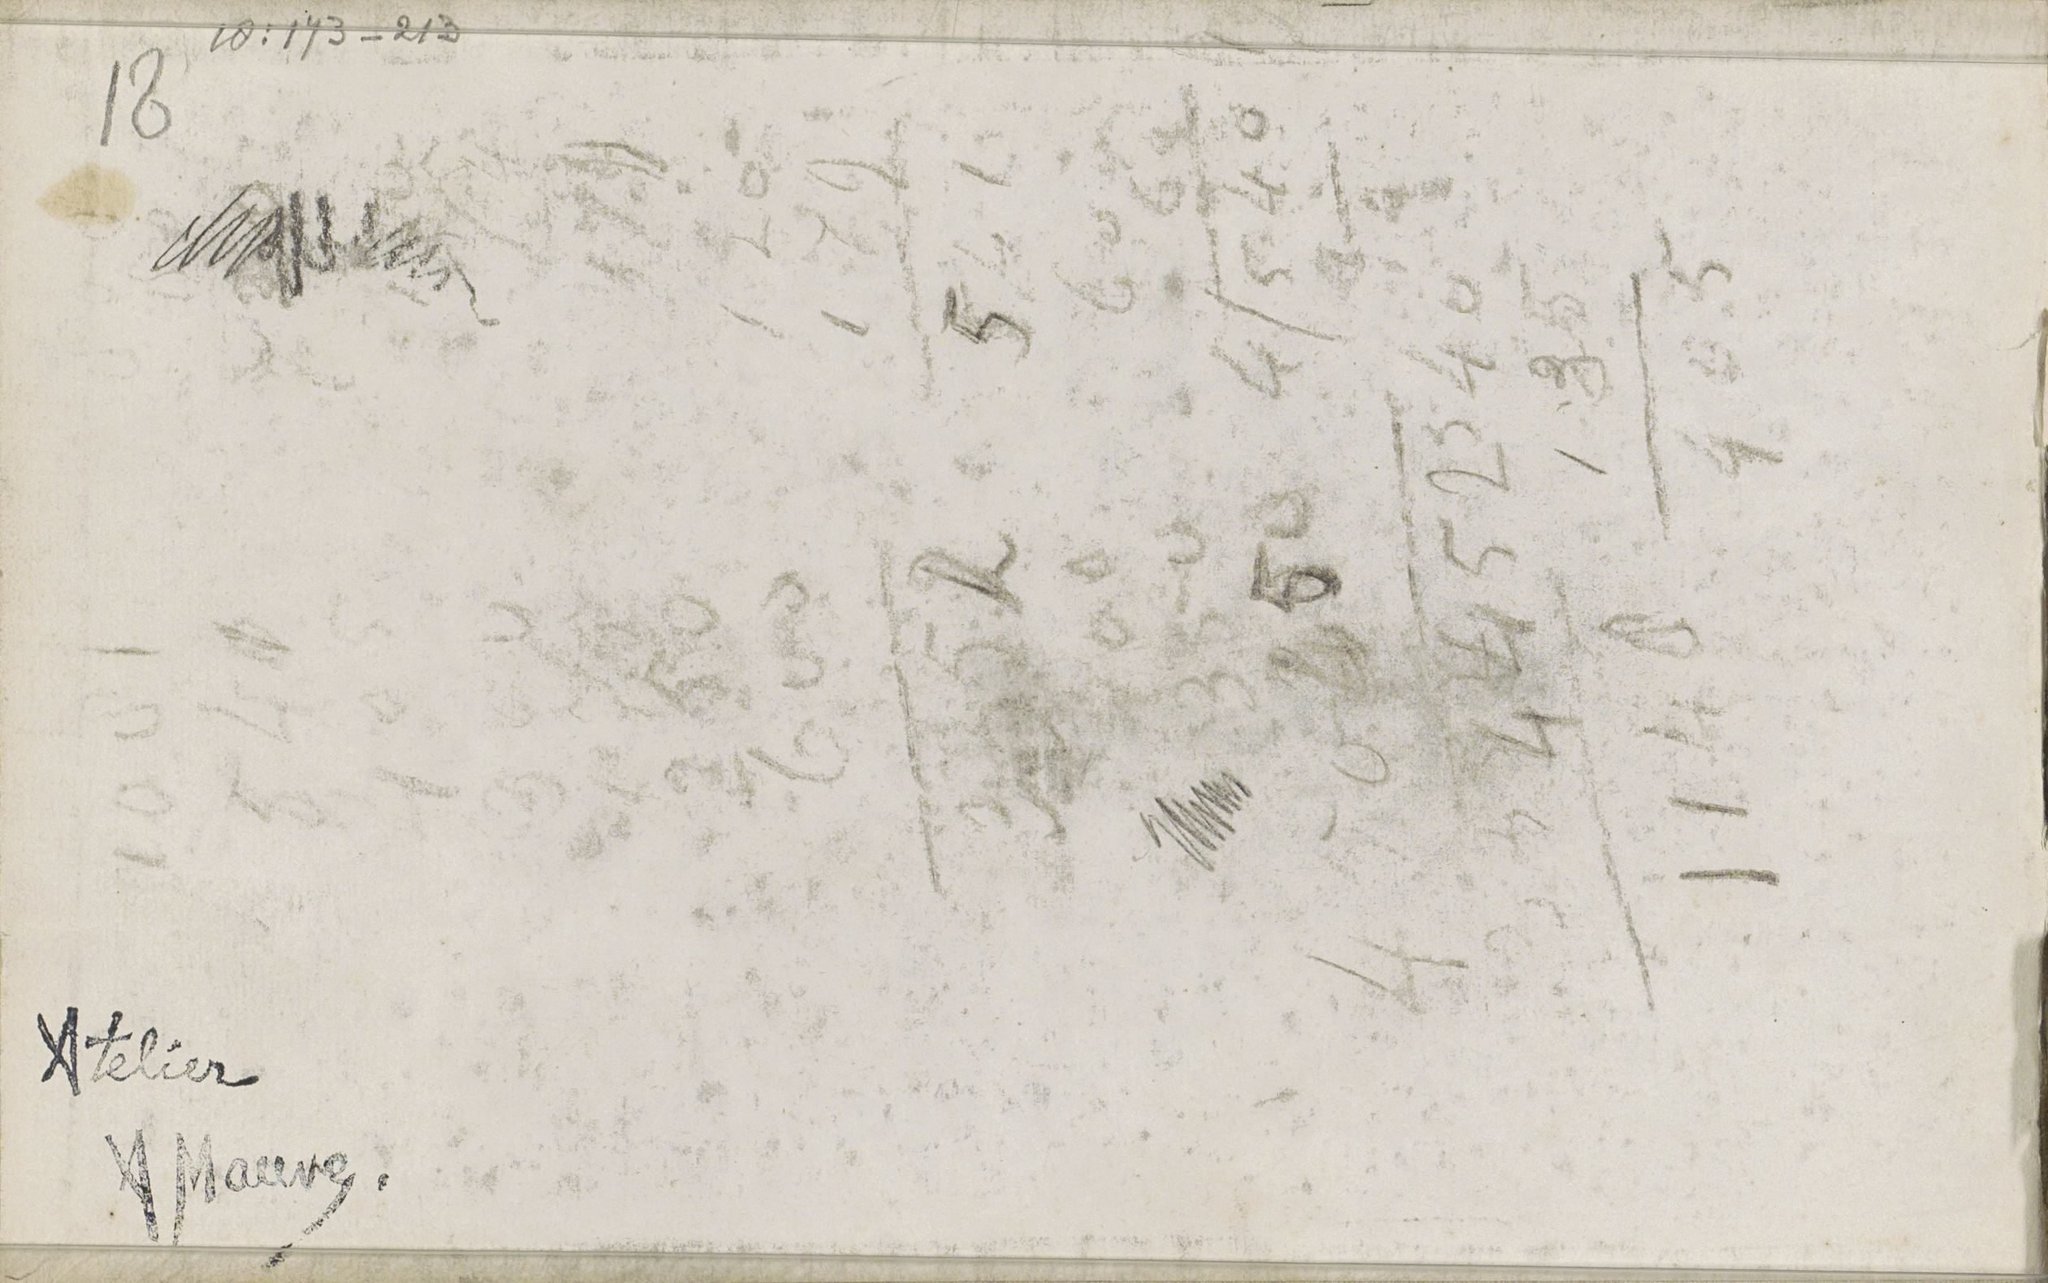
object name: sketchbook leaf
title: Berekeningen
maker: anton mauve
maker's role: draughtsman, painter, print maker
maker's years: 1838-1888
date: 1848-1888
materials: chalk, paper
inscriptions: annotation: ‘[...]’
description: Voorste schutblad uit een schetsboek met 41 bladen.